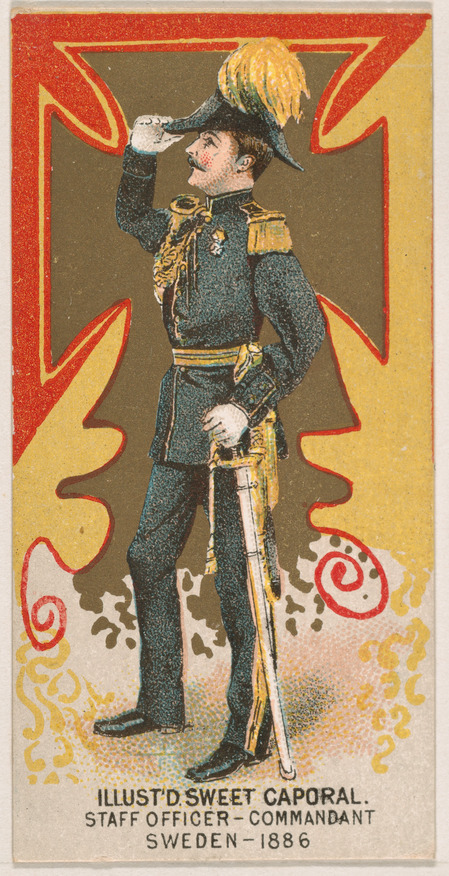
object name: print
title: Staff Officer-Commandant, Sweden, 1886, from the Military Series (N224) issued by Kinney Tobacco Company to promote Sweet Caporal Cigarettes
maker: kinney brothers tobacco company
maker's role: publisher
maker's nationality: american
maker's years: 1869-2011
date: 1888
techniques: color lithograph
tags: military,men,profiles